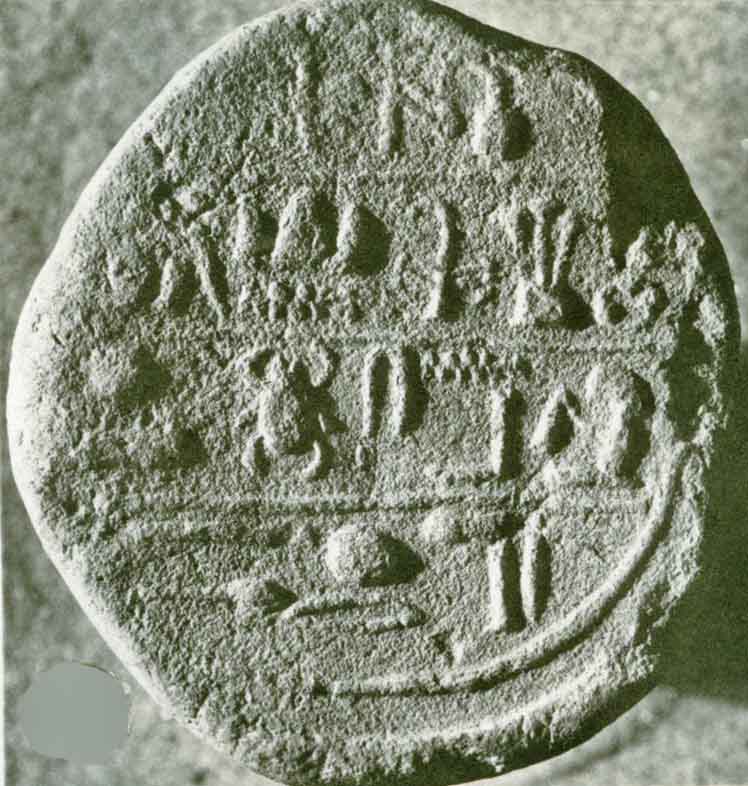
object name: cone, circular impression, menkheperreseneb, royal scribe, double granary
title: Funerary Cone of the Royal Scribe Menkheperreseneb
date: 1550-1295 BCE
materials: pottery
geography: egypt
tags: hieroglyphs